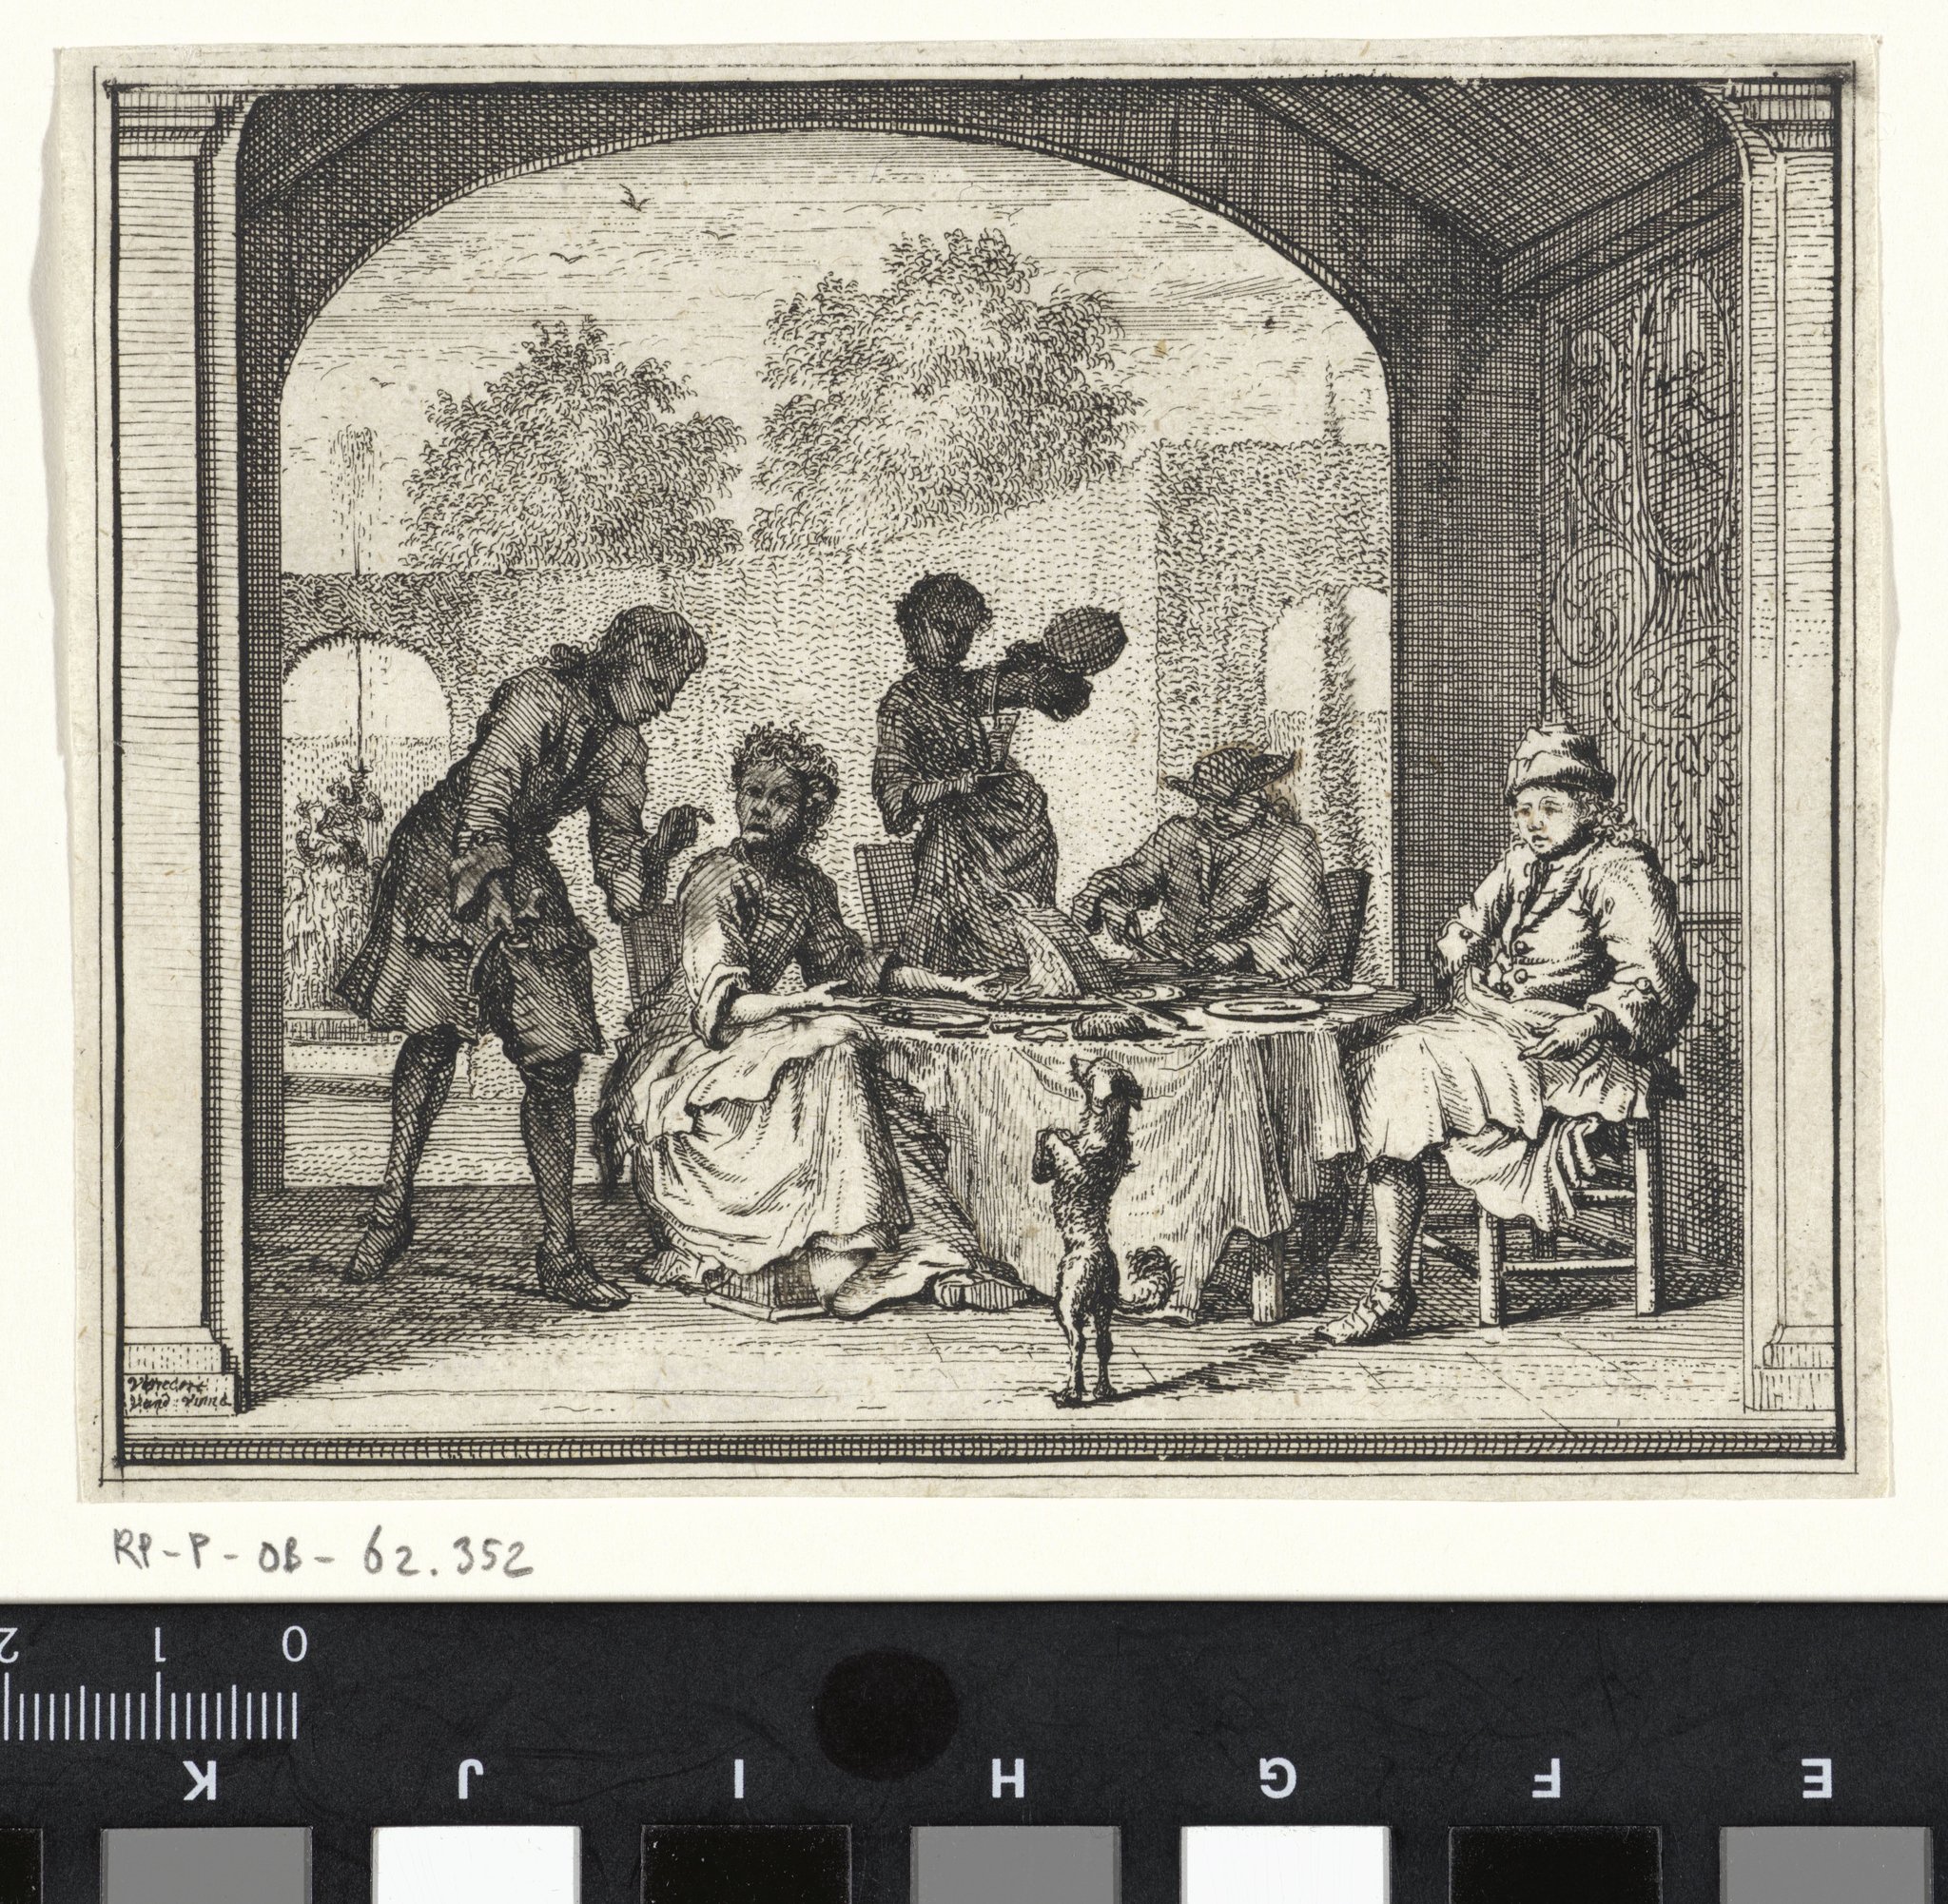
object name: print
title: Hond op achterpoten bij een gedekte tafel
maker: vincent laurensz. van der vinne (ii)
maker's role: draughtsman, print maker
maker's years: 1686-1742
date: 1714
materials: paper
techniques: engraving, etching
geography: haarlem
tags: (family) meal - cc - out of doors, dog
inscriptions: collector's mark: Lugt 2228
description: Verschillende figuren rond een gedekte tafel, met op de voorgrond een hond op zijn achterpoten. Zinnebeeld op het ijdel vragen en bidden van de mens, terwijl die toch zal ontvangen wat voor hem bepaald is.